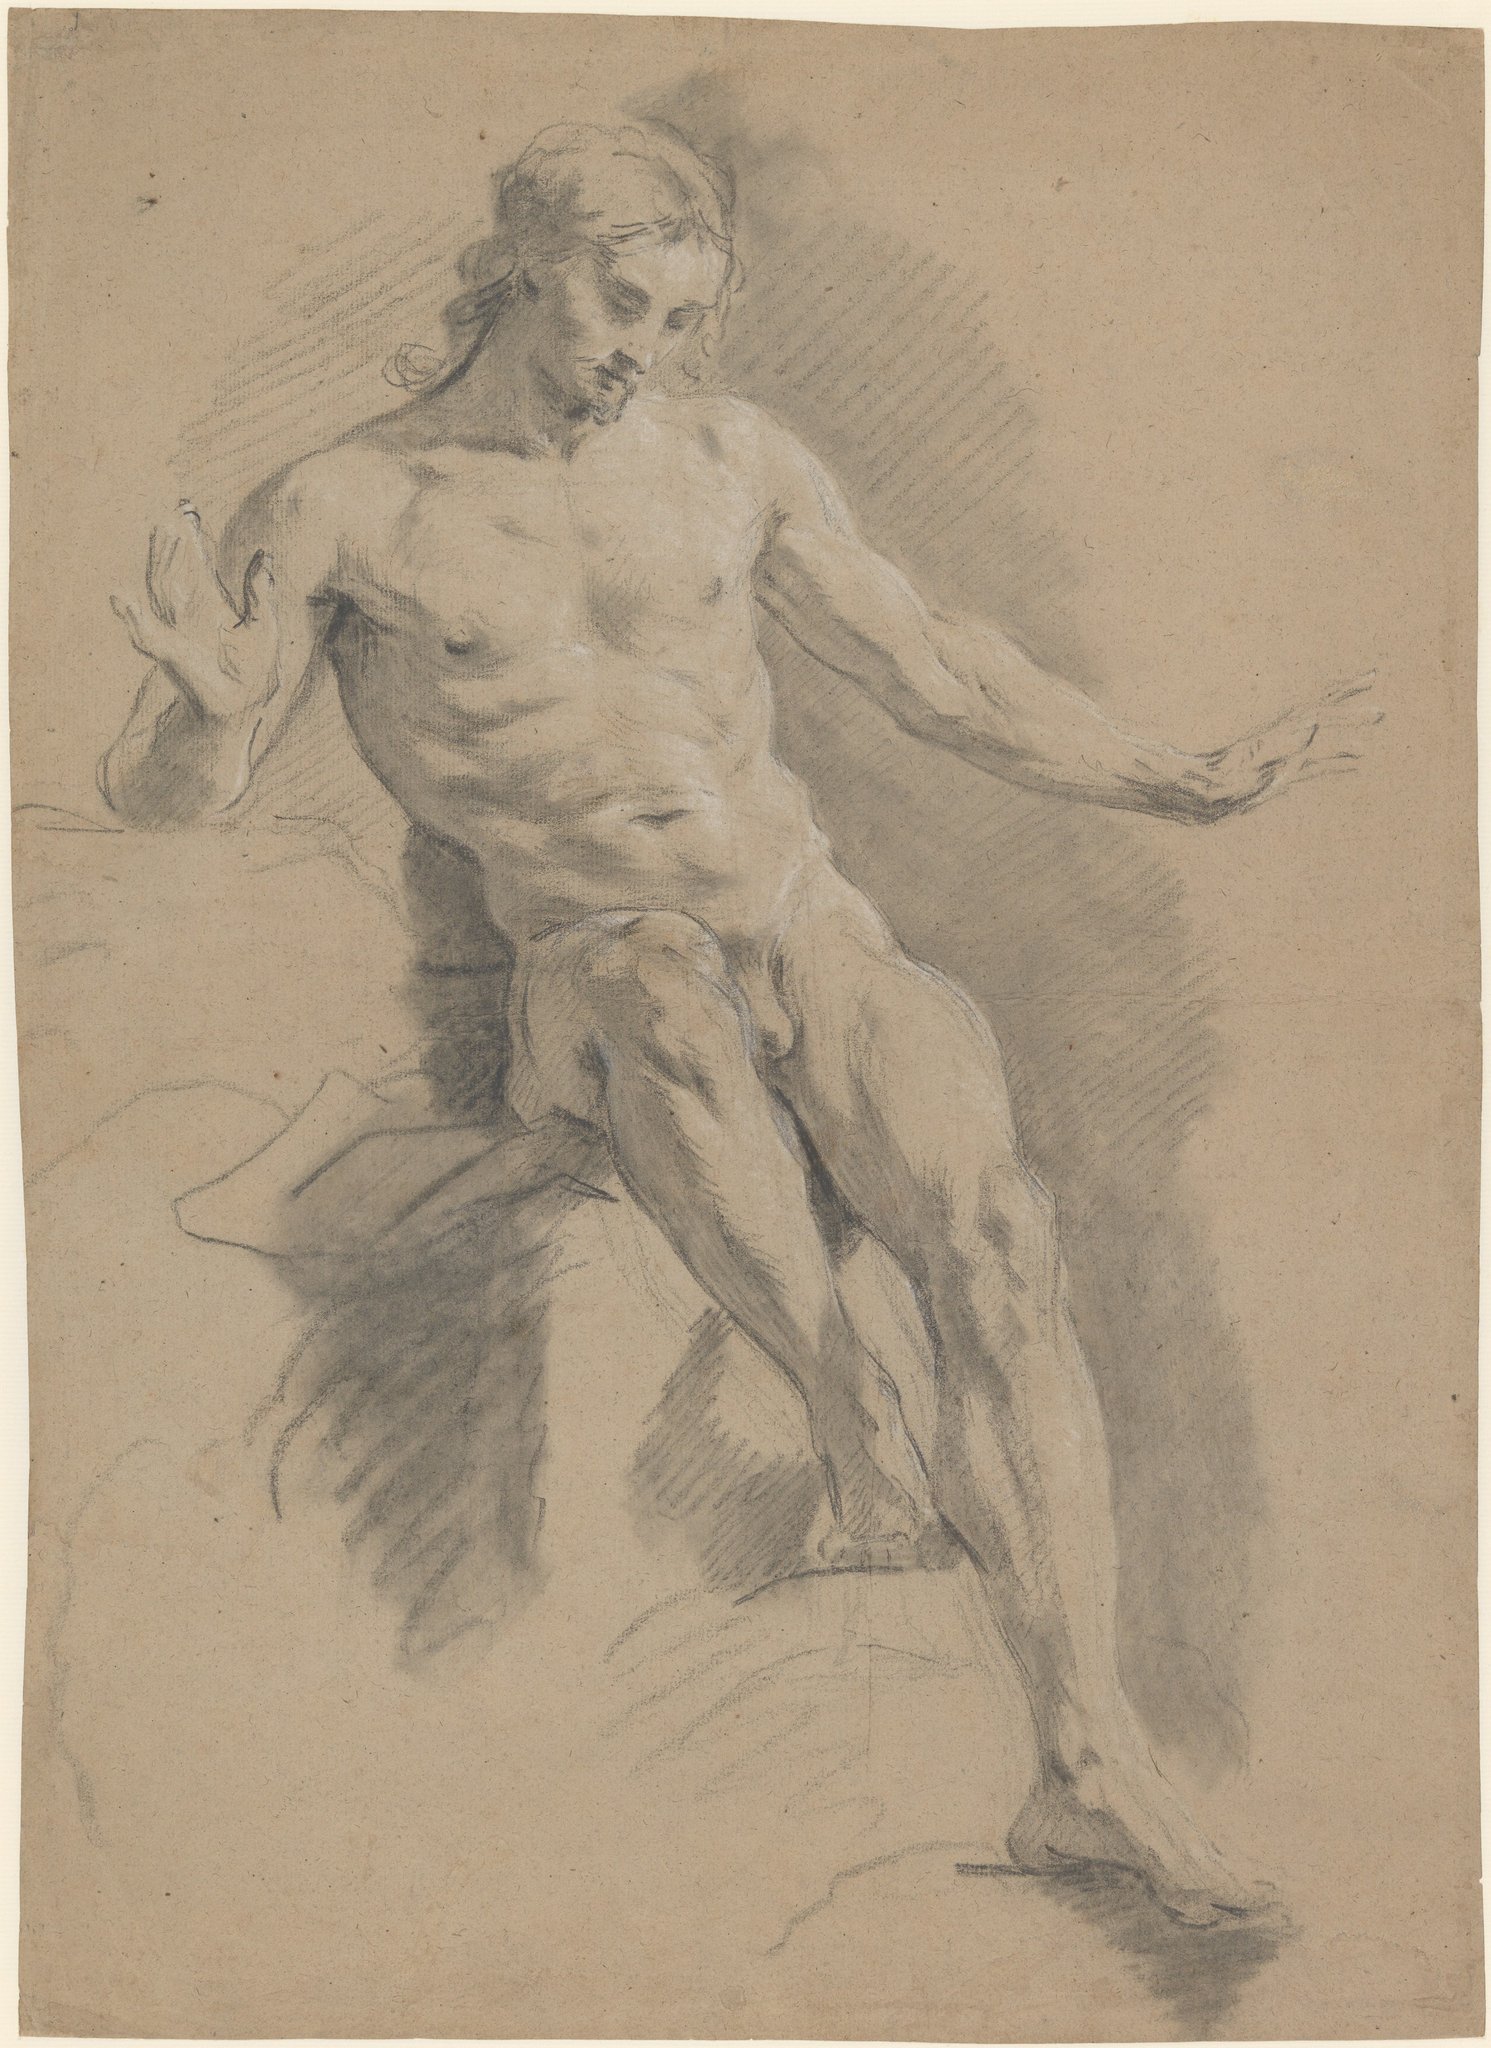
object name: drawing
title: Seated Male Nude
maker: jean restout le jeune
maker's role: artist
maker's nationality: french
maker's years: 1692-1768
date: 1740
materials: chalk, paper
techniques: heightening, stumping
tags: male nudes